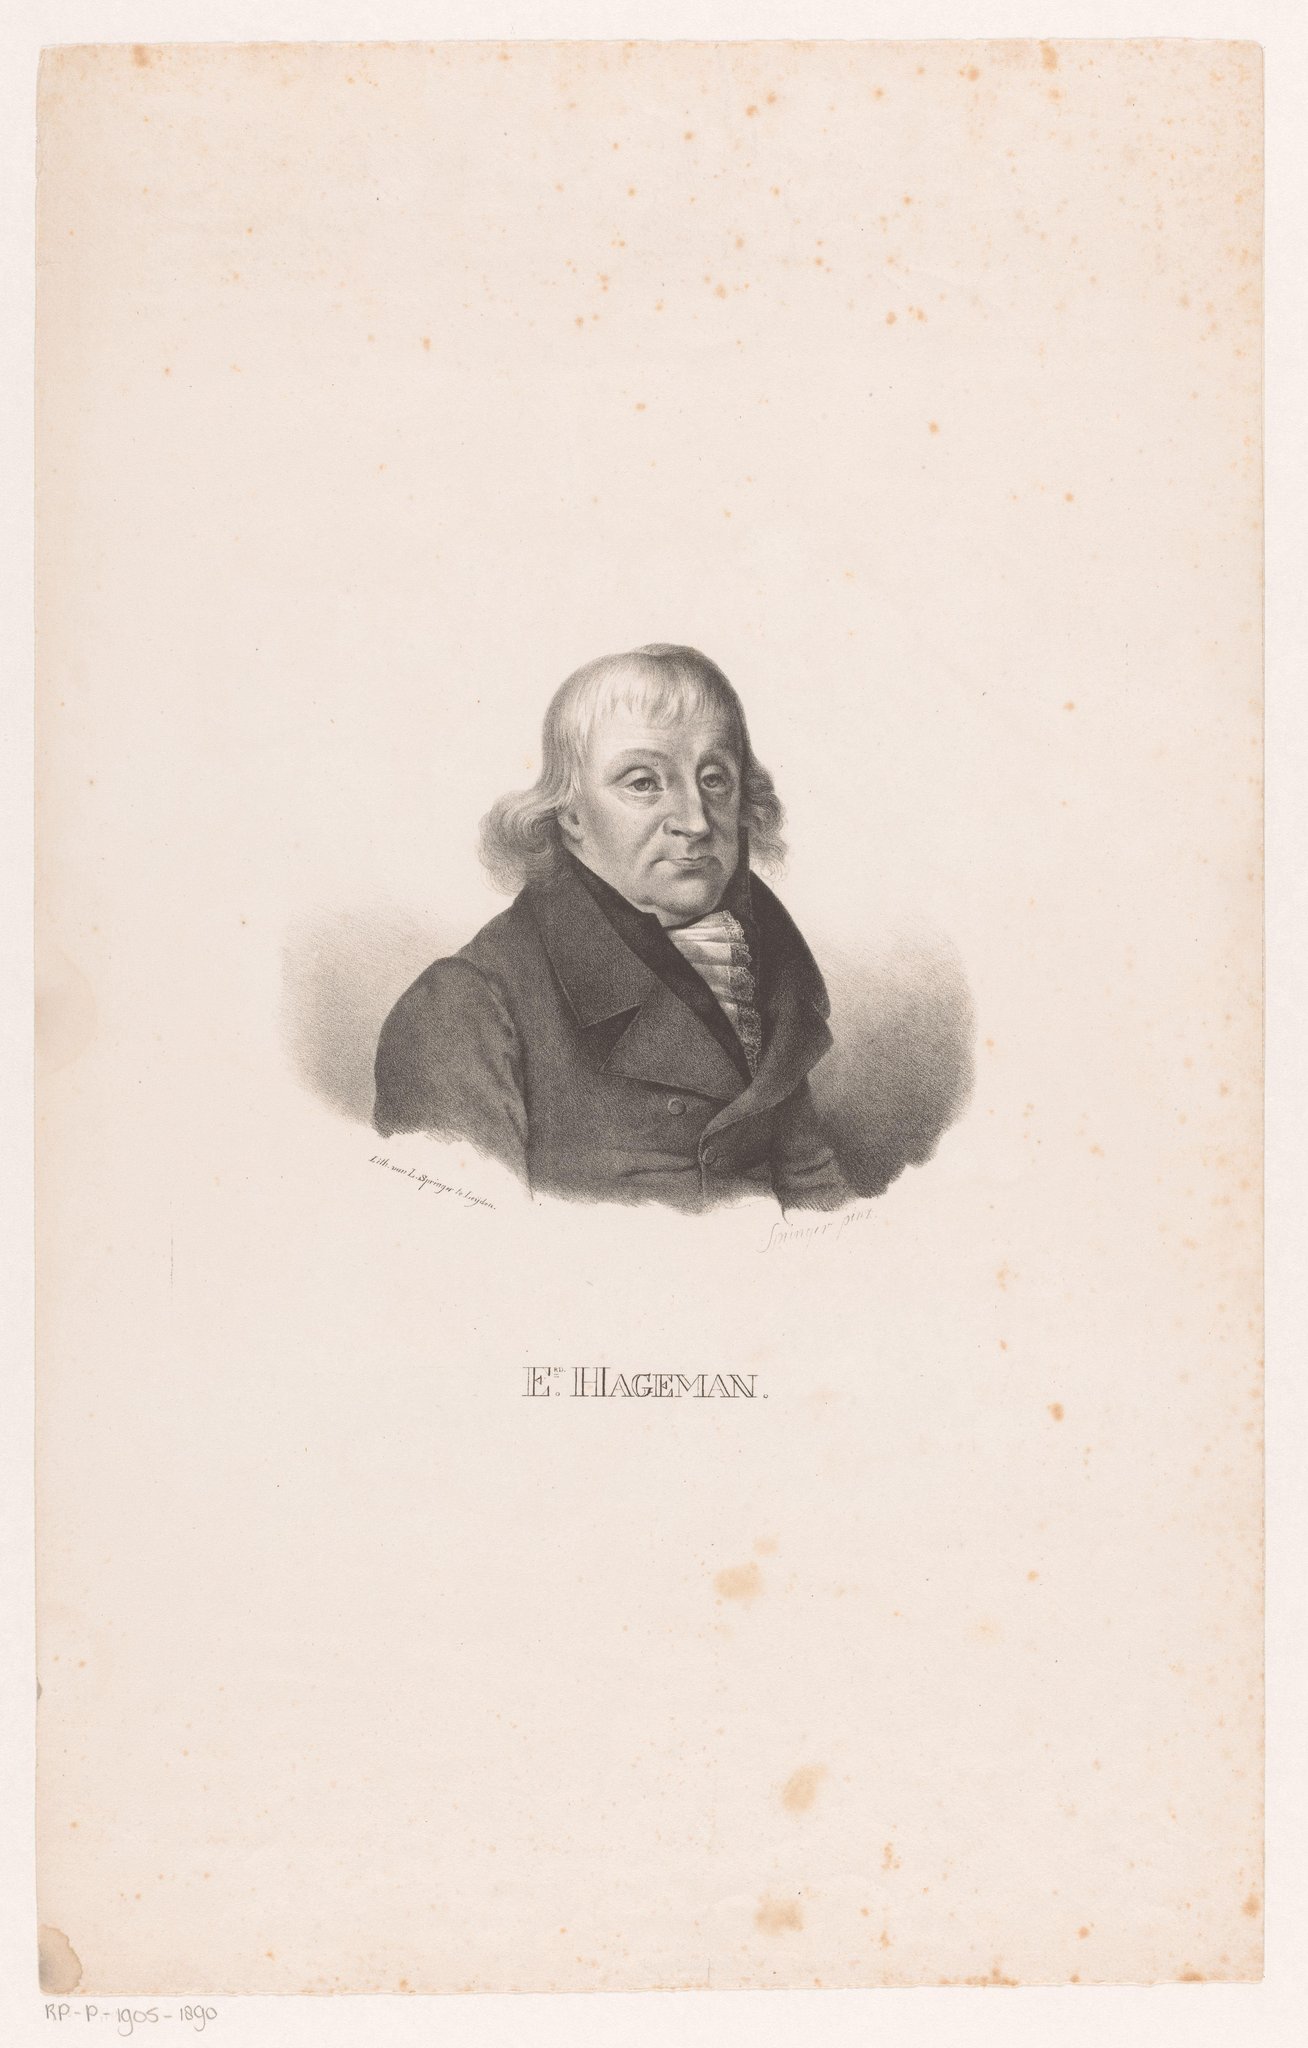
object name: print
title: Portret van Eduard Hageman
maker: leendert springer (i)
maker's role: draughtsman, painter, print maker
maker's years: 1789-1871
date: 1809-1853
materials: paper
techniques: lithograph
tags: historical persons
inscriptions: collector's mark: Lugt 2228